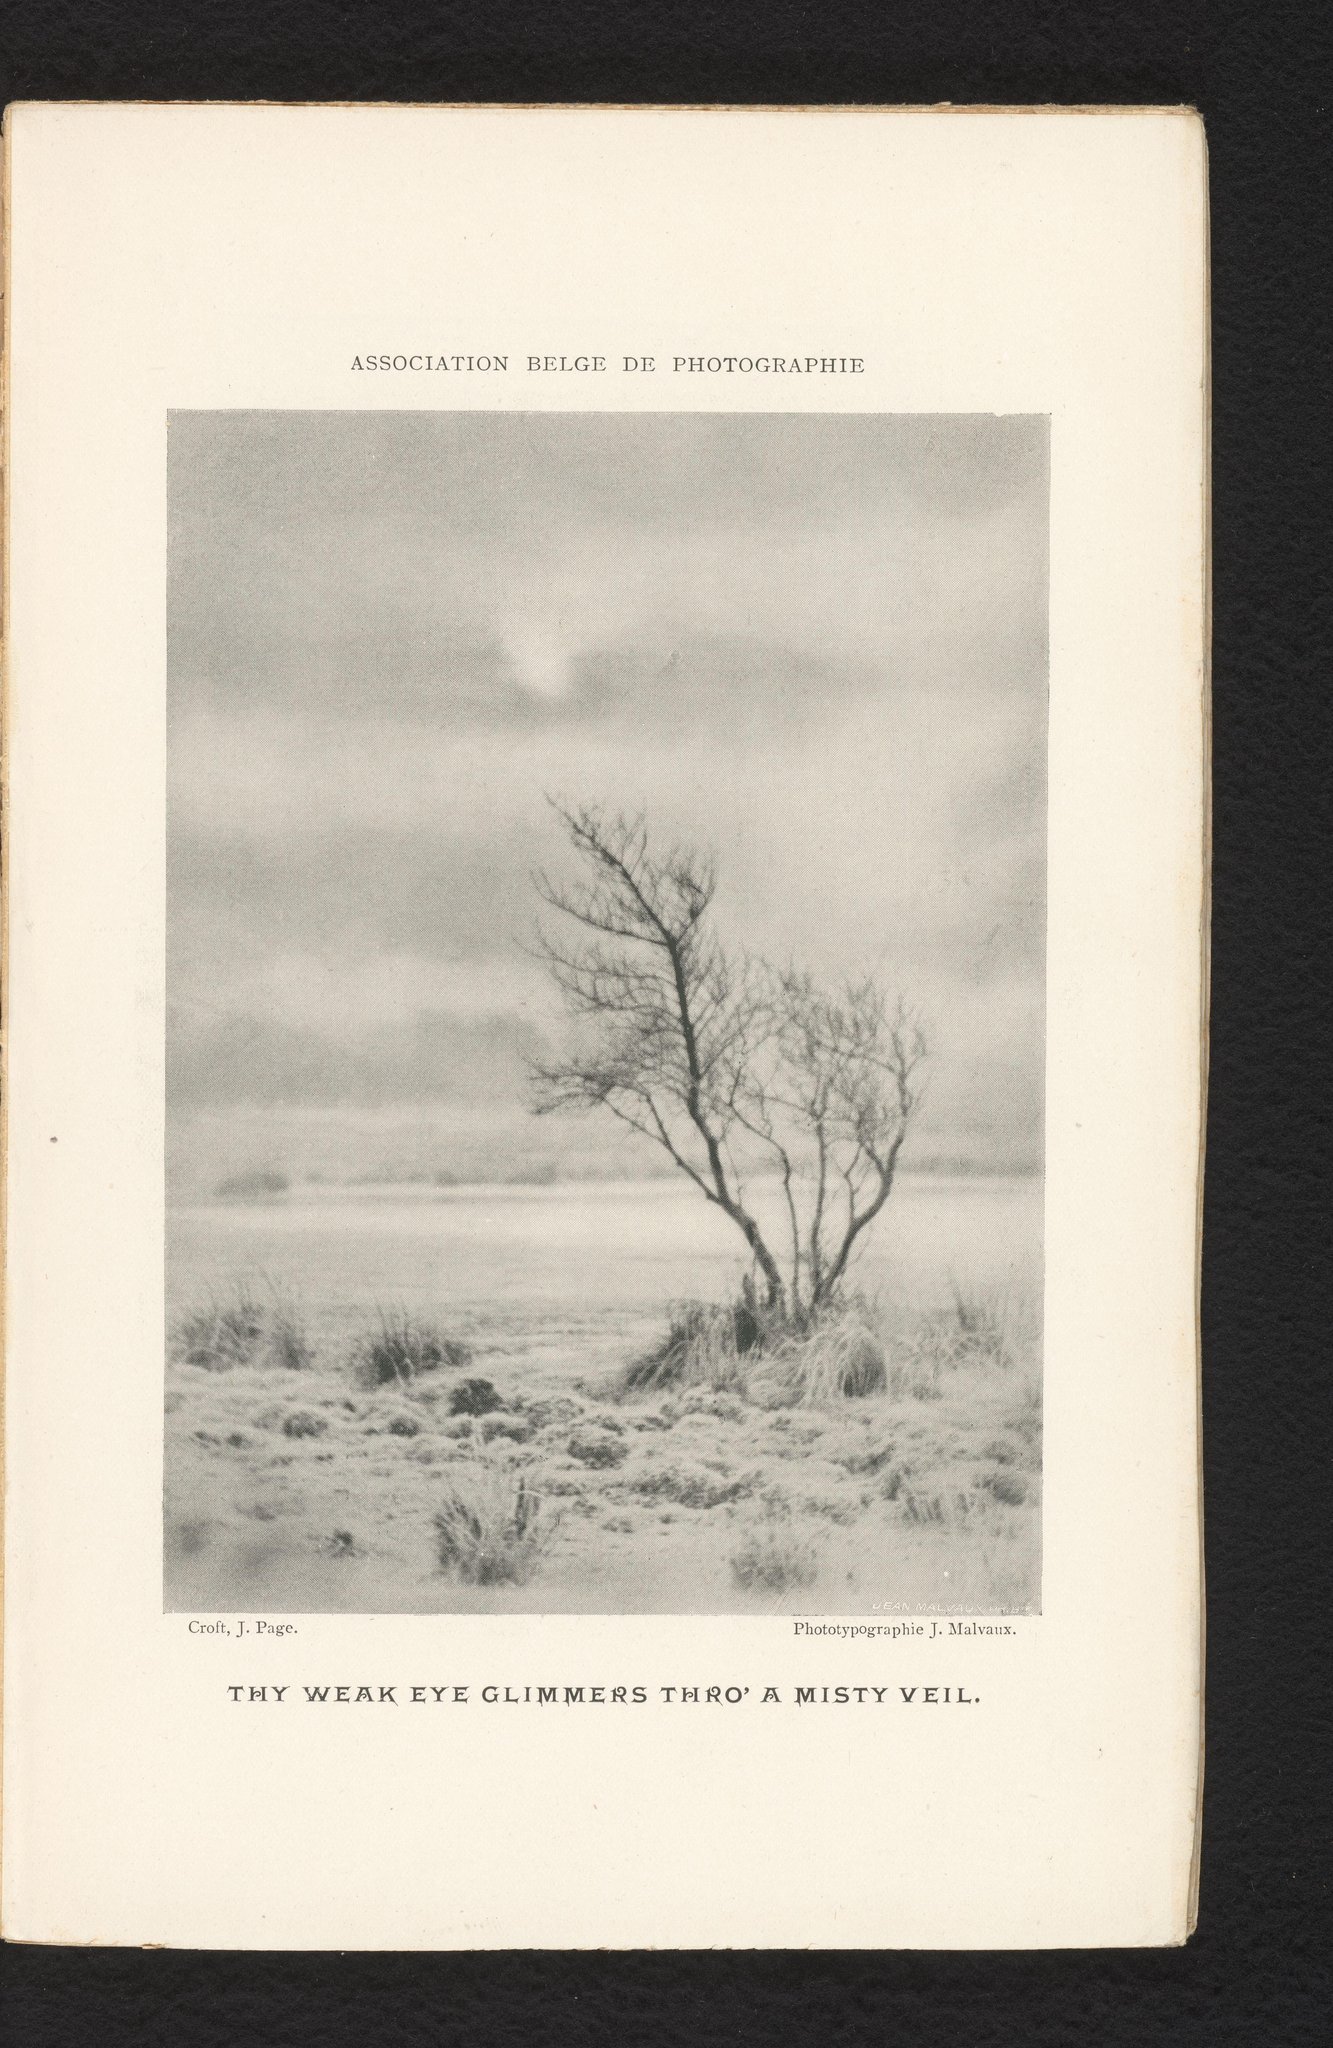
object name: photomechanical print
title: Winterlandschap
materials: paper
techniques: autotype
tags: winter landscape; landscape symbolizing winter (the four seasons of the year)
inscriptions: inscription: ‘ASSOCIATION BELGE DE PHOTOGRAPHIE’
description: Prent op derde ongenummerde pagina na pagina XVI.